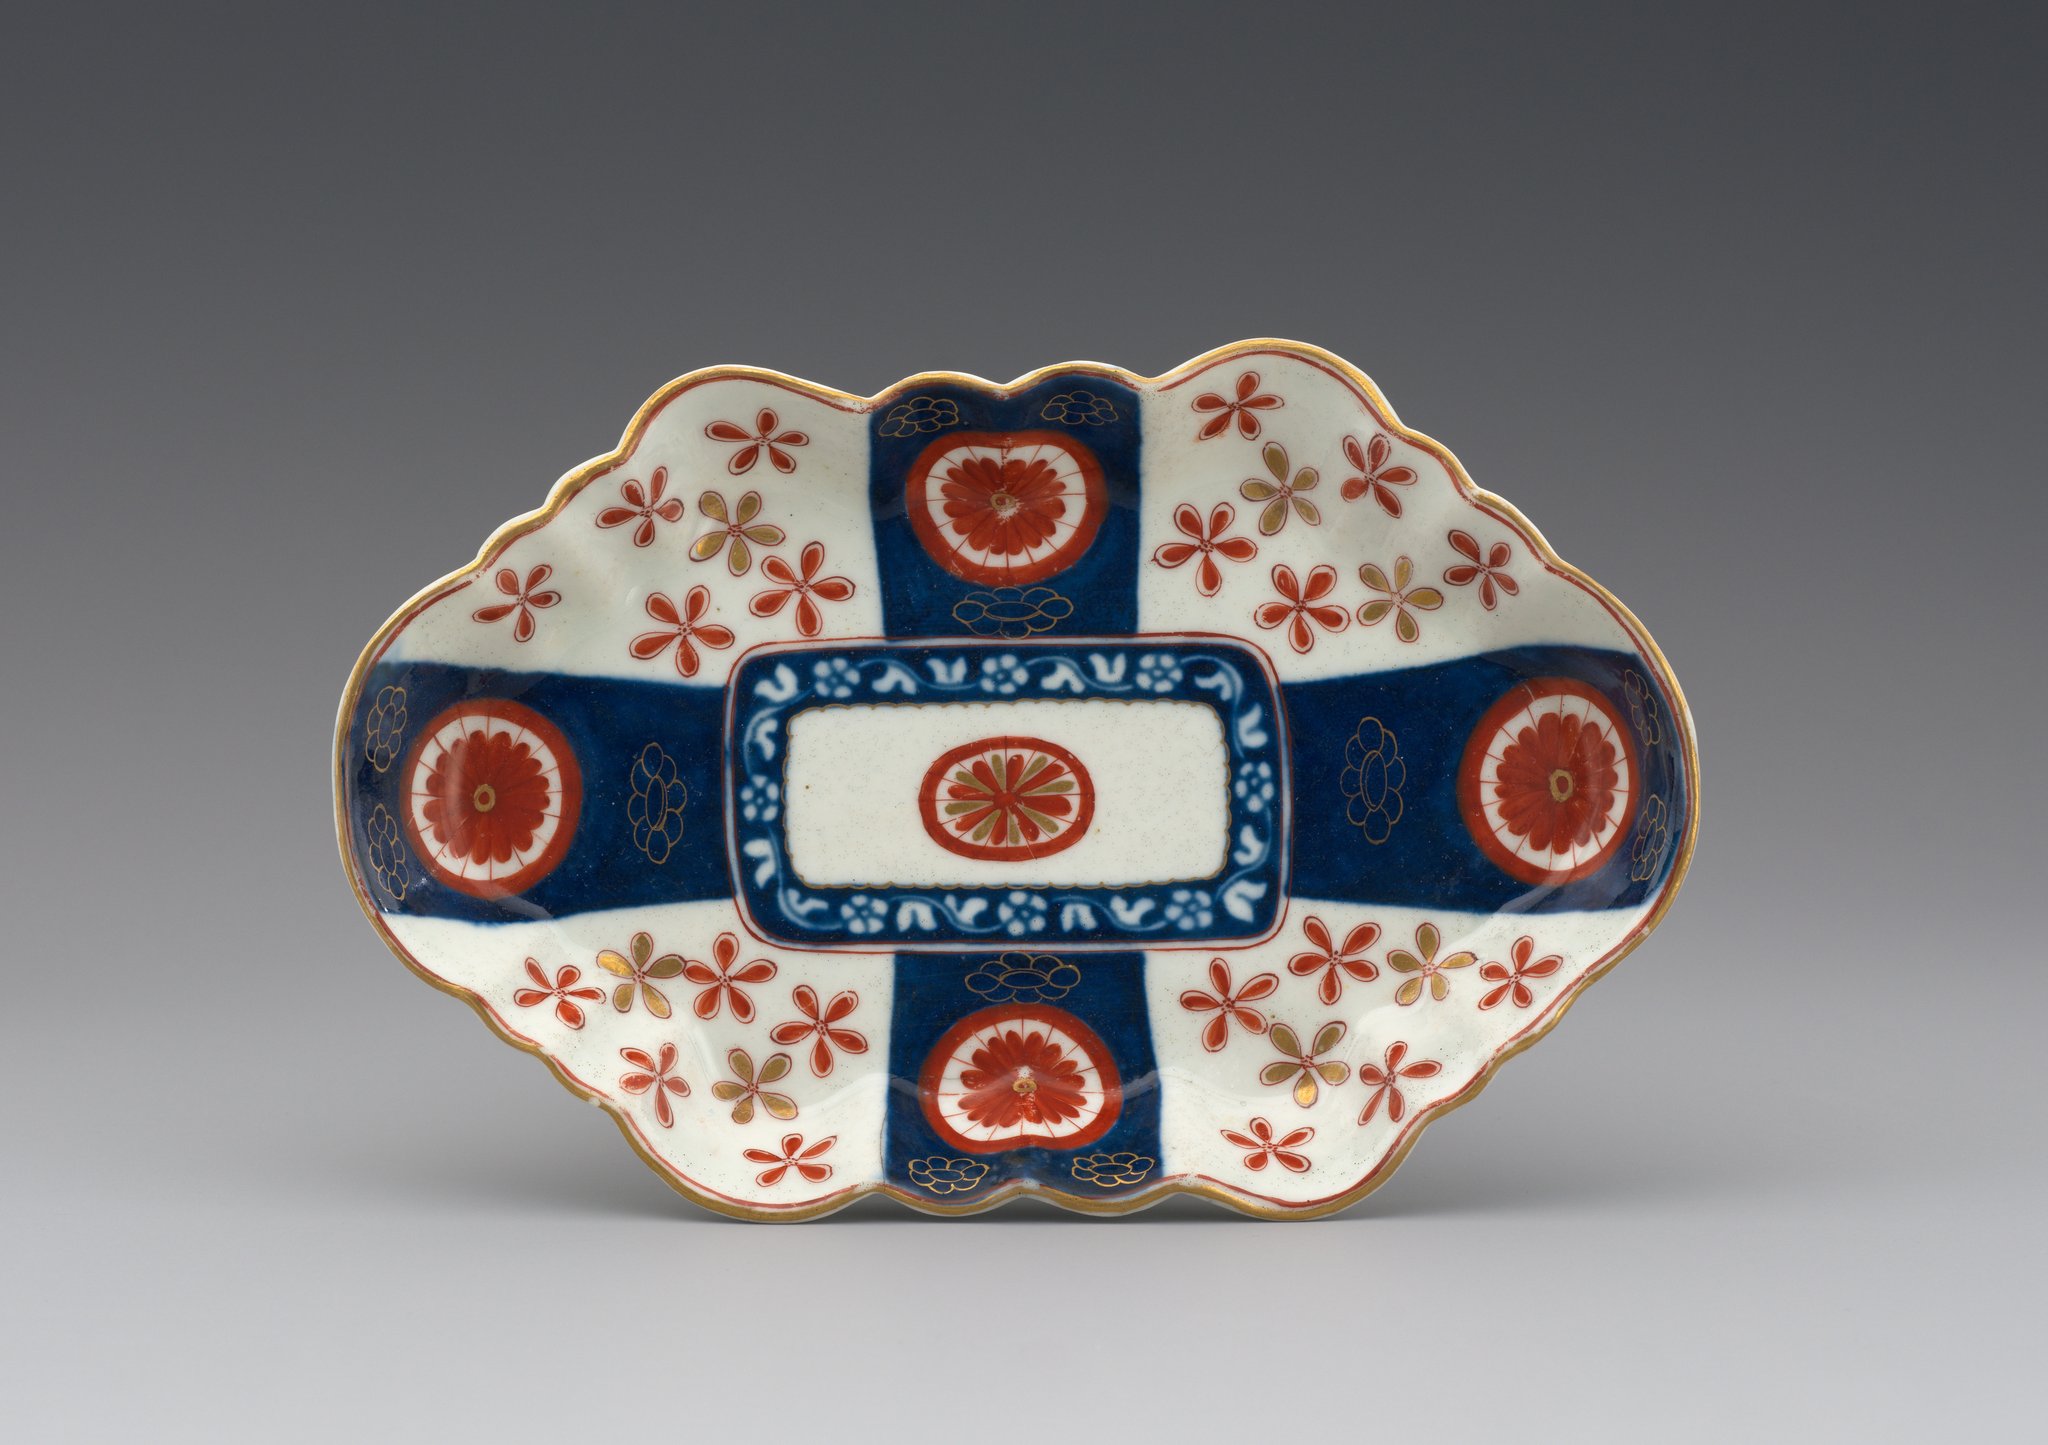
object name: spoon tray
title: Spoon tray (part of a service)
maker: worcester factory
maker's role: factory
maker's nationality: british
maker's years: 1751-2008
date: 1765-1775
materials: soft paste porcelain